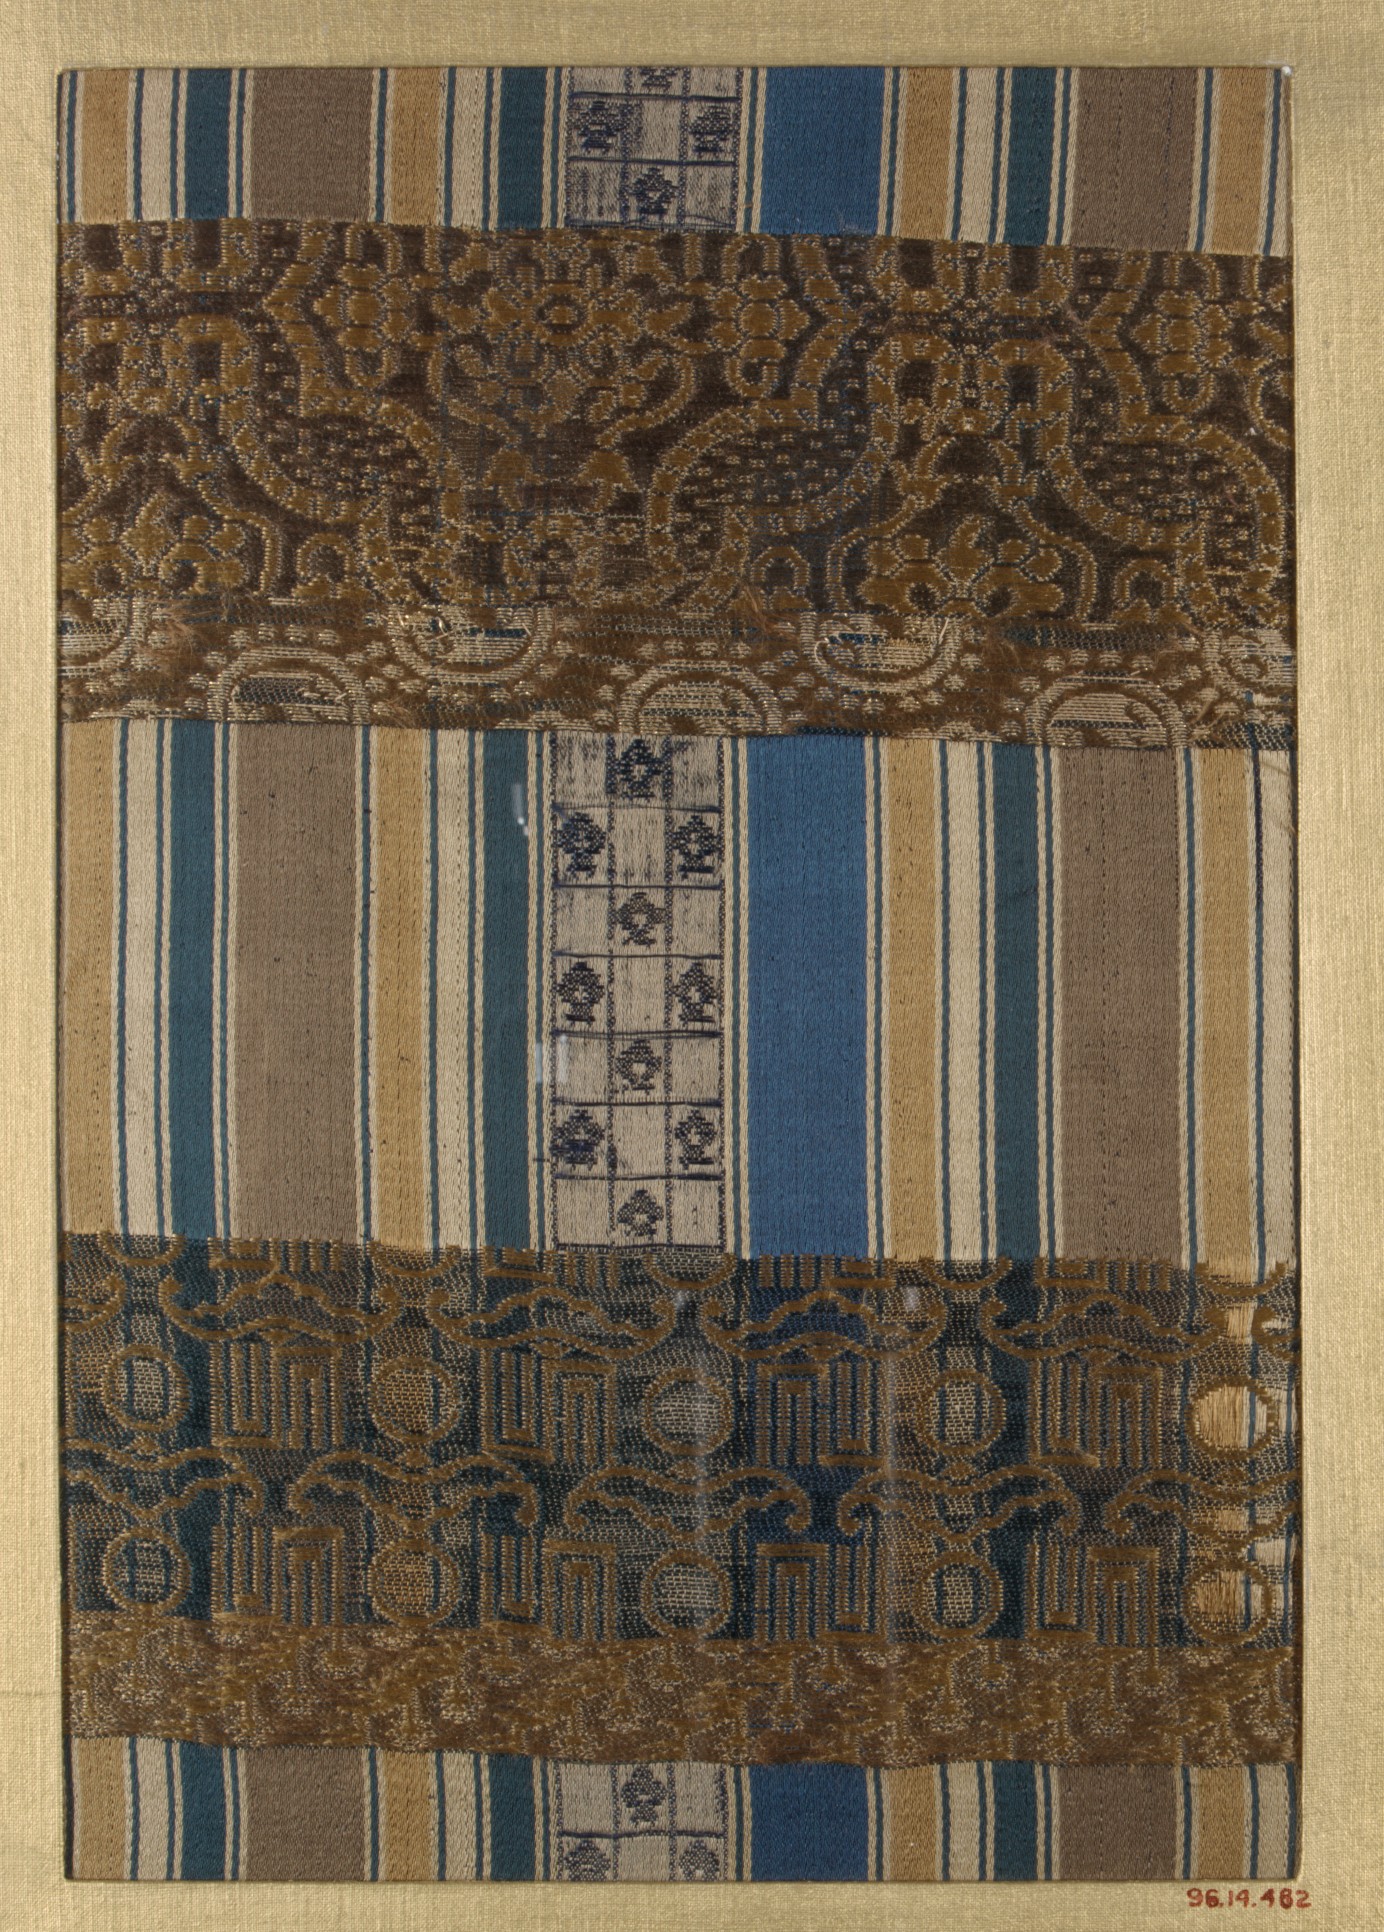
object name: fragment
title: Textile fragment with repeating pattern of stripes and figured bands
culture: japanese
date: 1701-1900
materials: silk